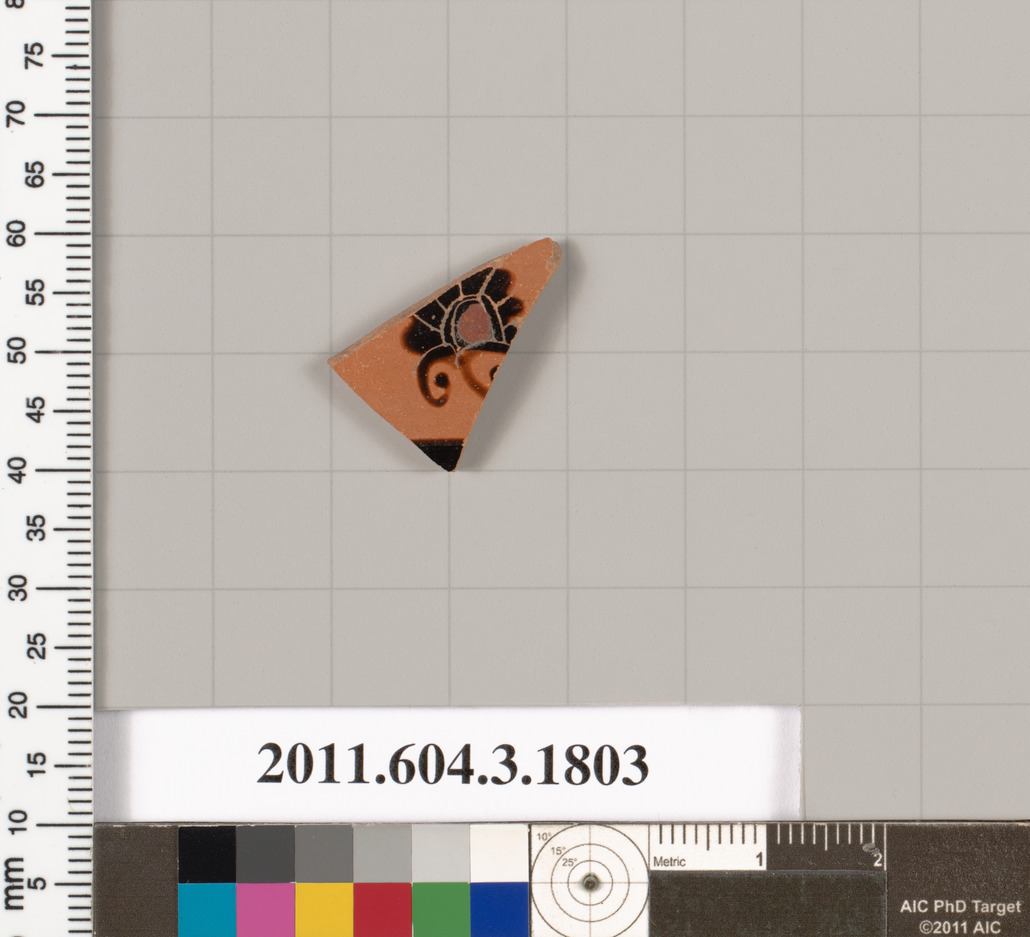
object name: kylix fragment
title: Terracotta fragment of a kylix: Lip cup (drinking cup)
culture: greek, attic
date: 567-535 BCE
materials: terracotta